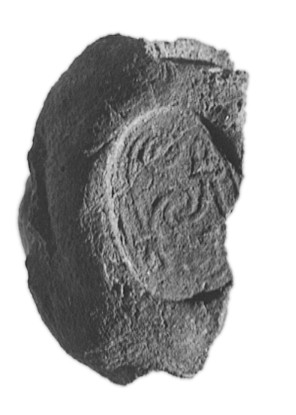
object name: sealing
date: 2030-1640 BCE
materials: clay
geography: egypt